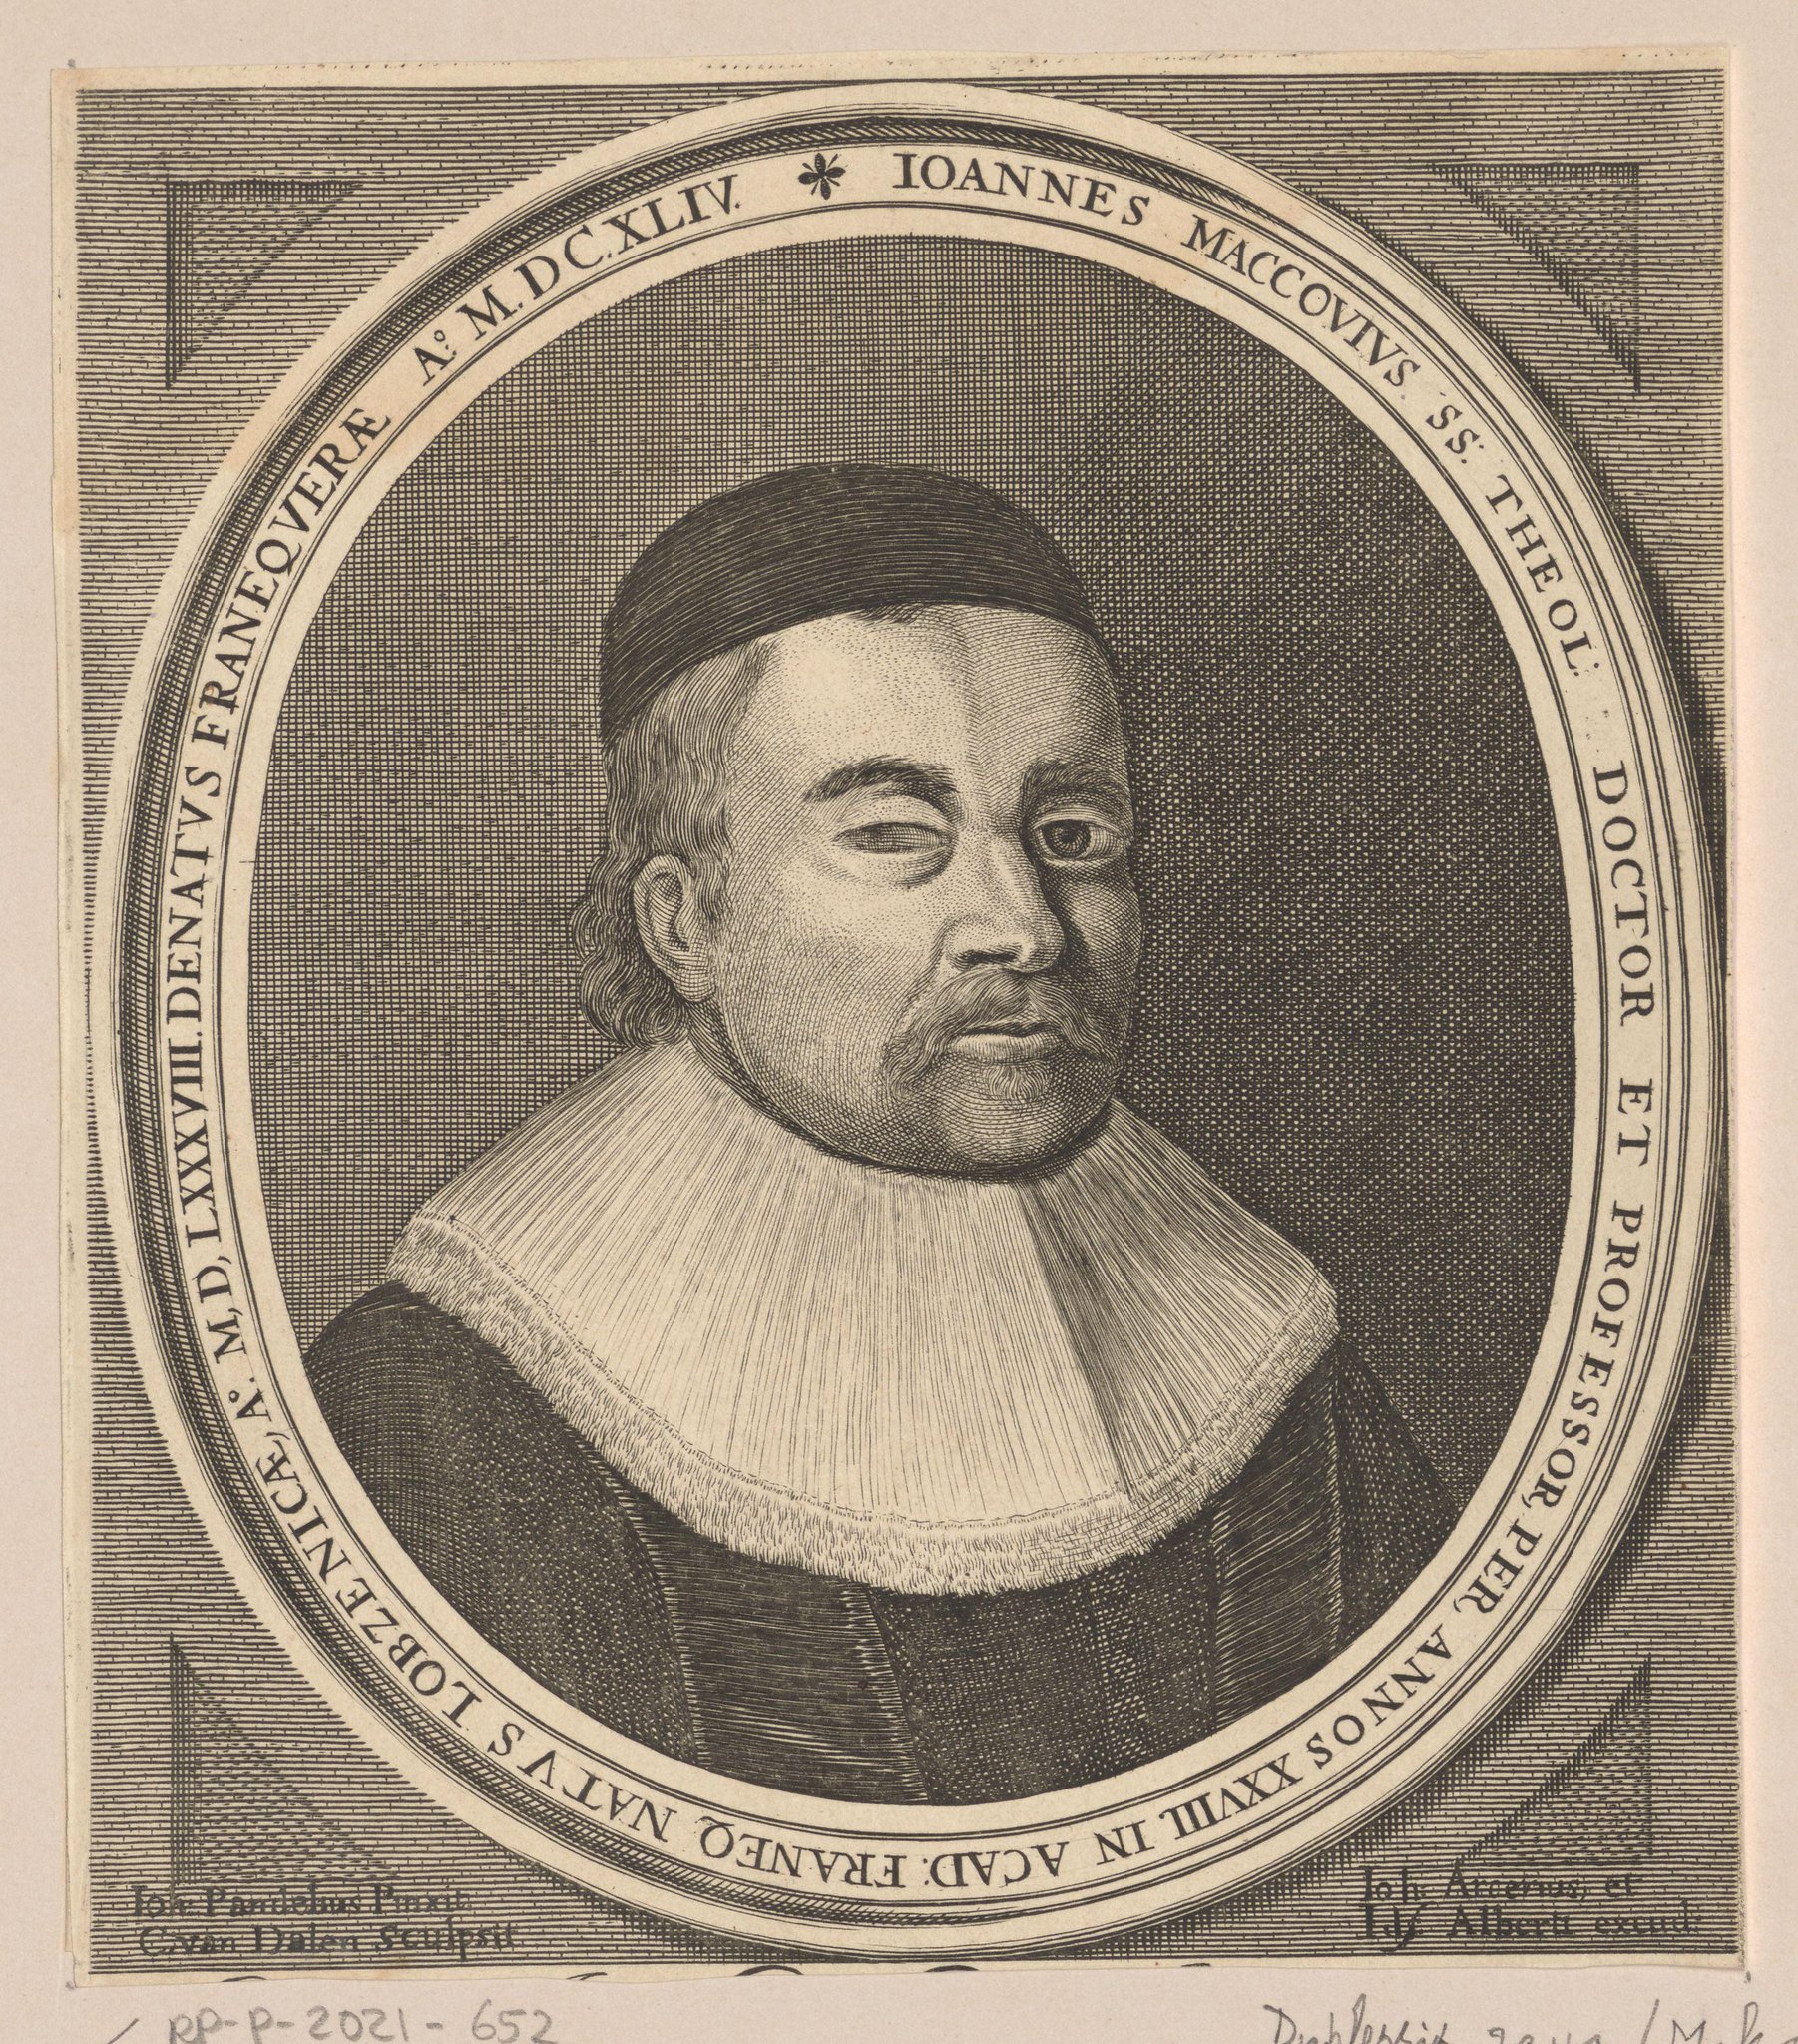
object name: print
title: Portret van Johannes Maccovius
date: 1644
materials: paper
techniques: engraving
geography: london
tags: politician, theologian, historical persons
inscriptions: date